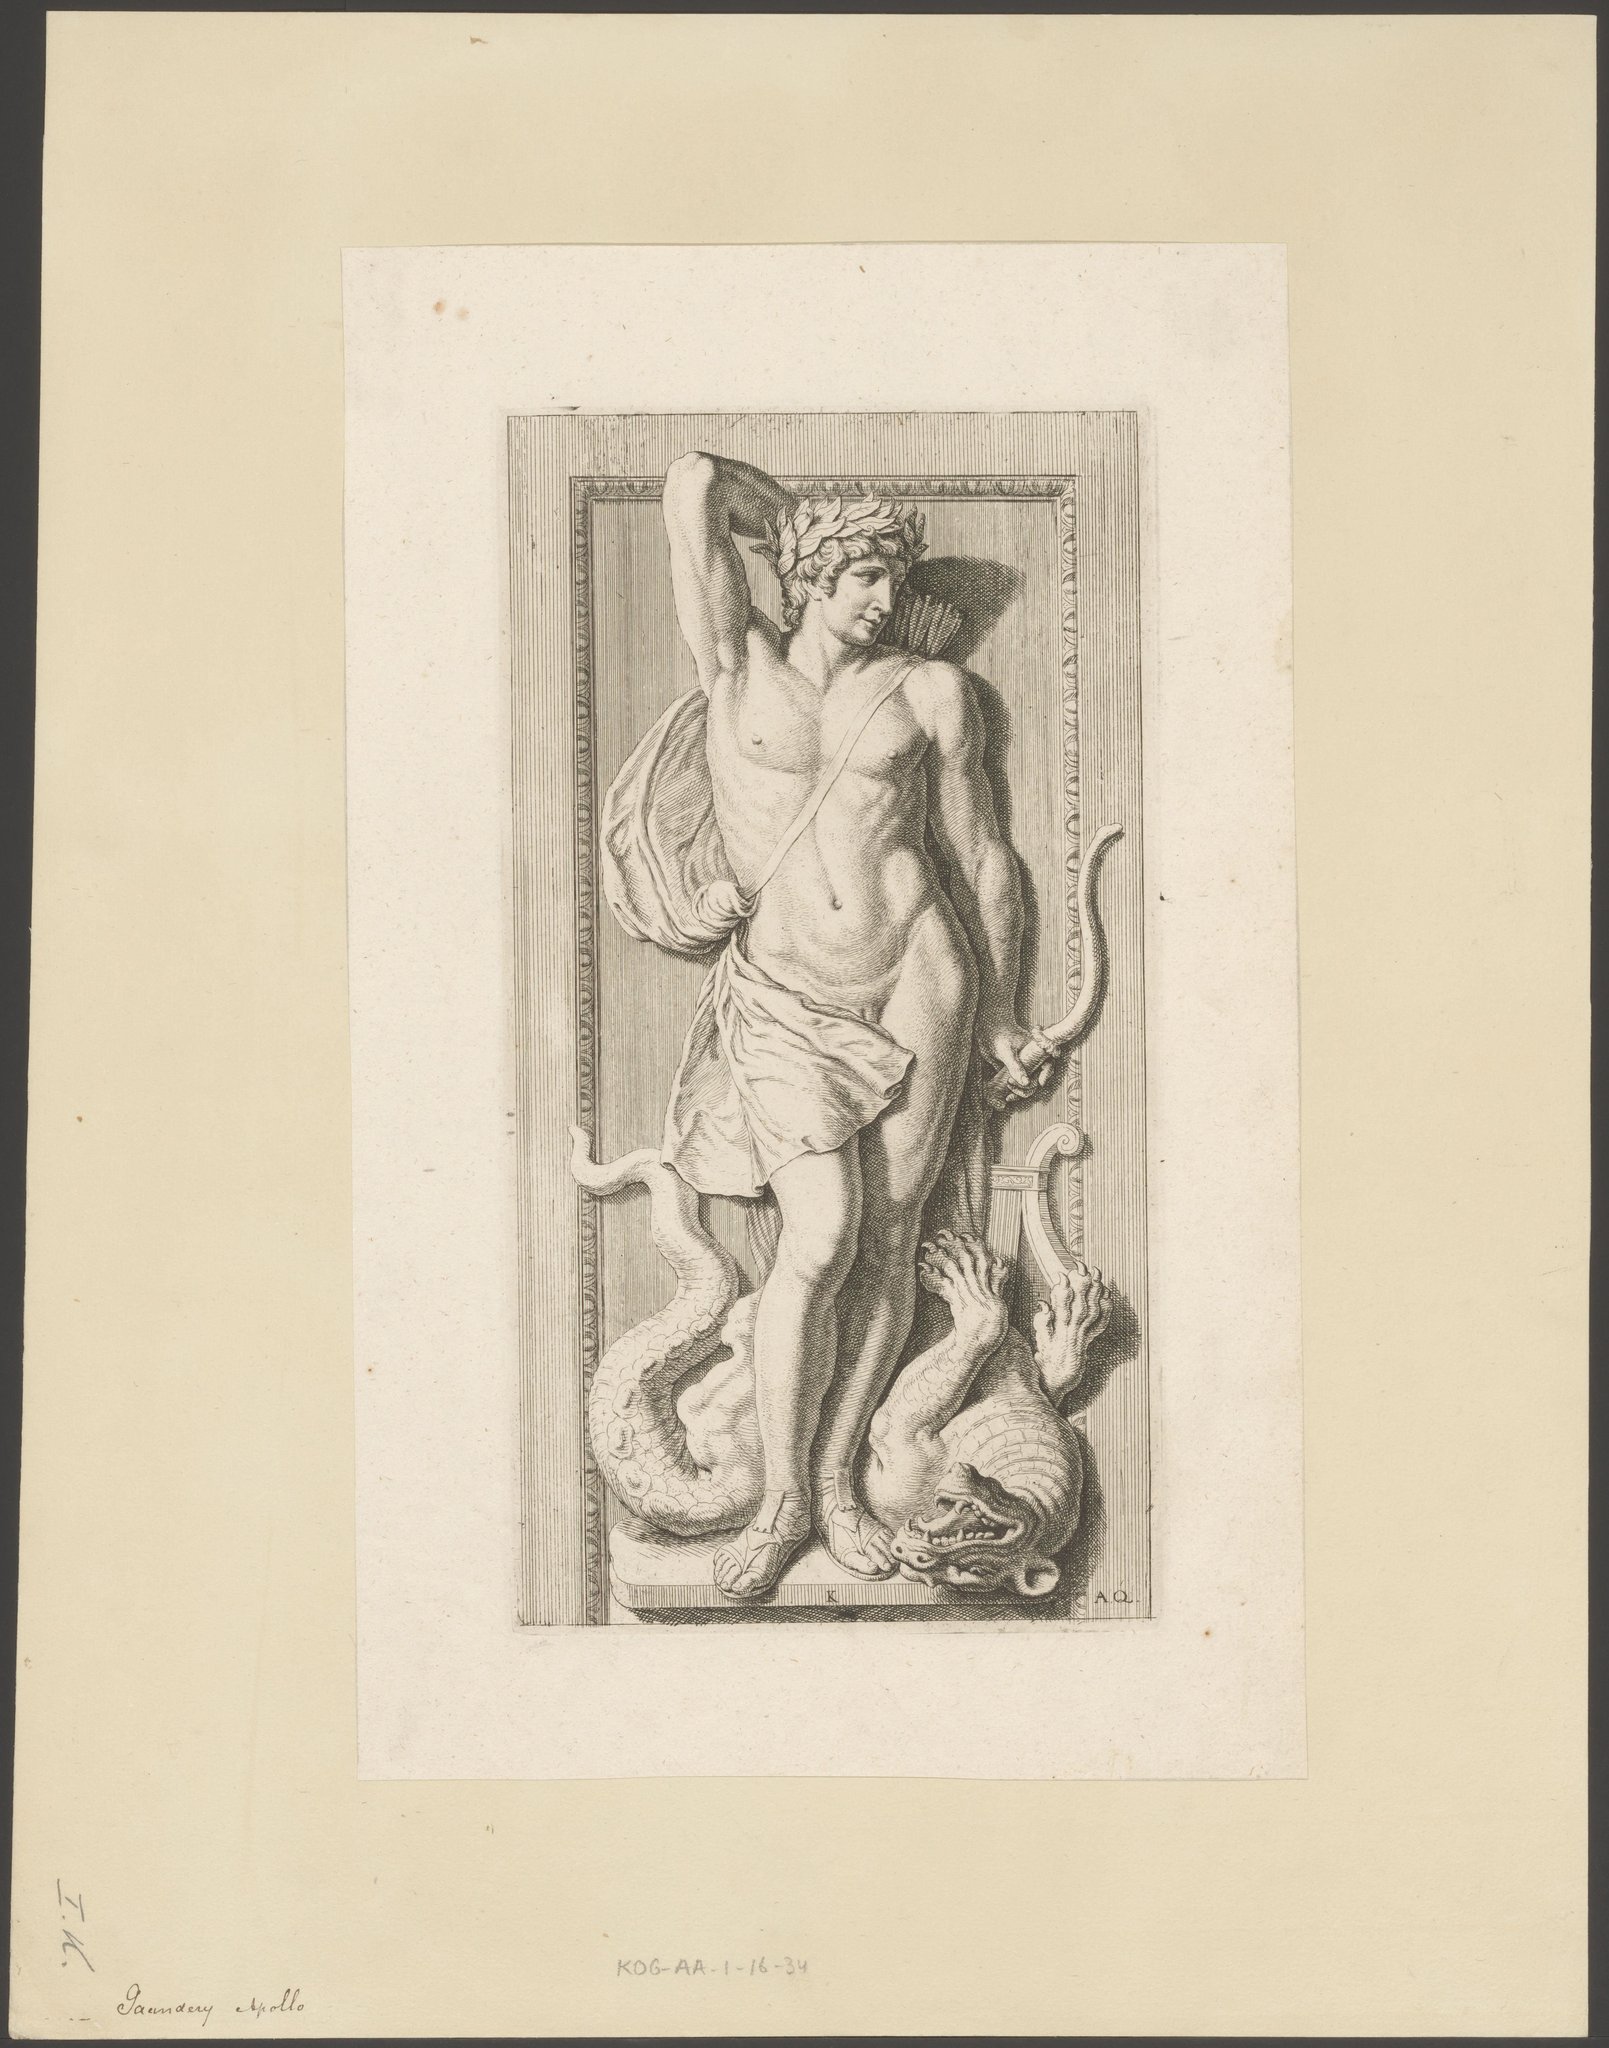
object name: print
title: Beeld van Apollo in de westelijke galerij van het Stadhuis op de Dam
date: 1655-1665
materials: paper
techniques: engraving, etching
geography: amsterdam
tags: (story of) apollo (phoebus), townhall, attributes of apollo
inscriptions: collector's mark: ‘16,34’ Lugt 1641b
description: Prent gebruikt in: Prima pars. Praecipuarum effigierum ac ornamentorum, amplissimae Curiae Amstelrodamensis (…) / Het eerste deel. Van de voornaemste Statuen ende Ciraten, vant konstijck Stadhuys van Amstelredam, tmeeste in marmer gemaeckt, door Artus Quellinus, Beelthouwer der voorseyde Stadt / La Premier Partie. De plusieurs Figures et ornements, de la Maison de Ville d'Amsterdam (…). Amsterdam: Artus Quellinus (I), 1655. Zie RP-P-AO-22-1-1 voor bijhorende titelpagina. Zie RP-P-AO-22-1-2 voor bijhorend register. Zie RP-P-AO-22-1A, RP-P-AO-22-1B, RP-P-AO-22-1C, RP-P-AO-22-1D-1, RP-P-AO-22-1D-2, RP-P-AO-22-1E, RP-P-AO-22-1F, RP-P-AO-22-1G, RP-P-AO-22-1H, RP-P-AO-22-1I, RP-P-AO-22-1K-2, RP-P-AO-22-1K-3, RP-P-AO-22-1K-4, RP-P-AO-22-1K-5, RP-P-AO-22-1L-1, RP-P-AO-22-1L-2, RP-P-AO-22-1M-1, RP-P-AO-22-1M-2, RP-P-AO-22-1N-1, RP-P-AO-22-1N-2, RP-P-AO-22-1N-3, RP-P-AO-22-1N-4, RP-P-AO-22-1N-5, RP-P-AO-22-1O-1, RP-P-AO-22-1O-2, RP-P-AO-22-1O-3, RP-P-AO-22-1O-4, RP-P-AO-22-1P-1, RP-P-AO-22-1P-2, RP-P-AO-22-1P-3, RP-P-AO-22-1P-4, RP-P-AO-22-1Q-1, RP-P-AO-22-1Q-2, RP-P-AO-22-1Q-3, RP-P-AO-22-1Q-4, RP-P-AO-22-1R-1, RP-P-AO-22-1R-2, RP-P-AO-22-1R-3, RP-P-AO-22-1R-4, RP-P-AO-22-1R-5, RP-P-AO-22-1S-1, RP-P-AO-22-1S-2, RP-P-AO-22-1S-3, RP-P-AO-22-1S-4, RP-P-AO-22-1S-5, RP-P-AO-22-1T-1 en RP-P-AO-22-1T-2 voor andere prenten uit deze publicatie. Zelfde staat van prent ook gebruikt in: Prima pars. Praecipuarum effigierum ac ornamentorum, amplissimae Curiae Amstelrodamensis (…) / Het eerste deel. Van de voornaemste Statuen ende Ciraten, vant konstijck Stadhuys van Amstelredam, tmeeste in marmer gemaeckt, door Artus Quellinus, Beelthouwer der voorseyde Stadt / La Premier Partie. De plusieurs Figures et ornements, de la Maison de Ville d'Amsterdam (…). Amsterdam: Frederik de Wit, 1665. Latere staat van prent ook gebruikt in: Architecture peinture et sculpture de la Maison de Ville d'Amsterdam, representee en CIX. figures en taille-douce (…). Amsterdam: David Mortier, 1719. En in: Architecture peinture et sculpture de la Maison de Ville d'Amsterdam, representee en CIX. figures en taille-douce (…). Amsterdam: Gerard Valck, 1719. En in: Bouw schilder en beeldhouwkonst, van het Stadhuis te Amsteldam, vertoont in CIX figuuren (…). Amsterdam: Covens & Mortier & Covens Jr., s.a. (1774-1783). Zie BK-AM-51-19 voor een model van het beeld.